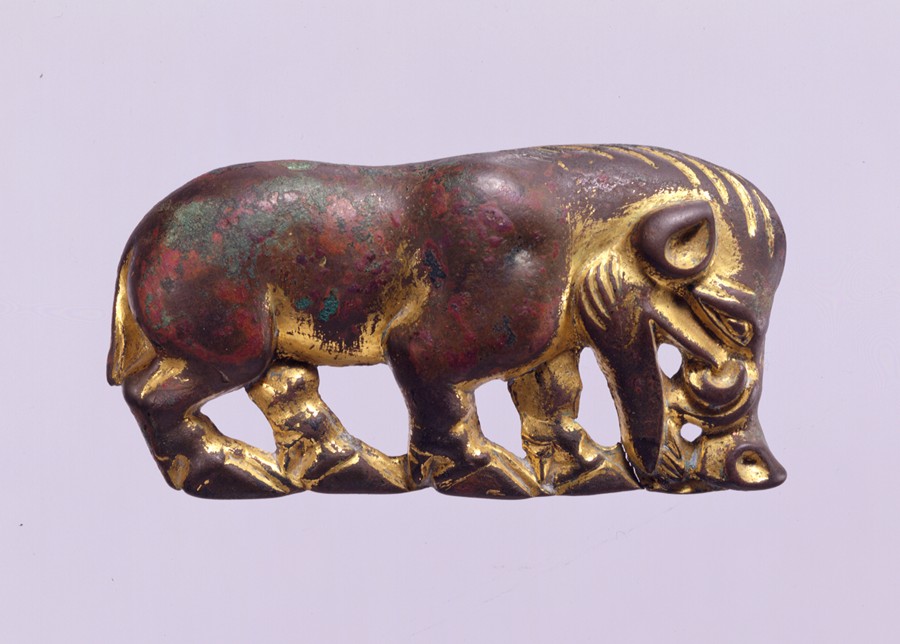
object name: belt plaque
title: Belt Plaque in the Shape of a Wild Boar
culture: northwest chinese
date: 300-101 BCE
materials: gilt bronze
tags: boars